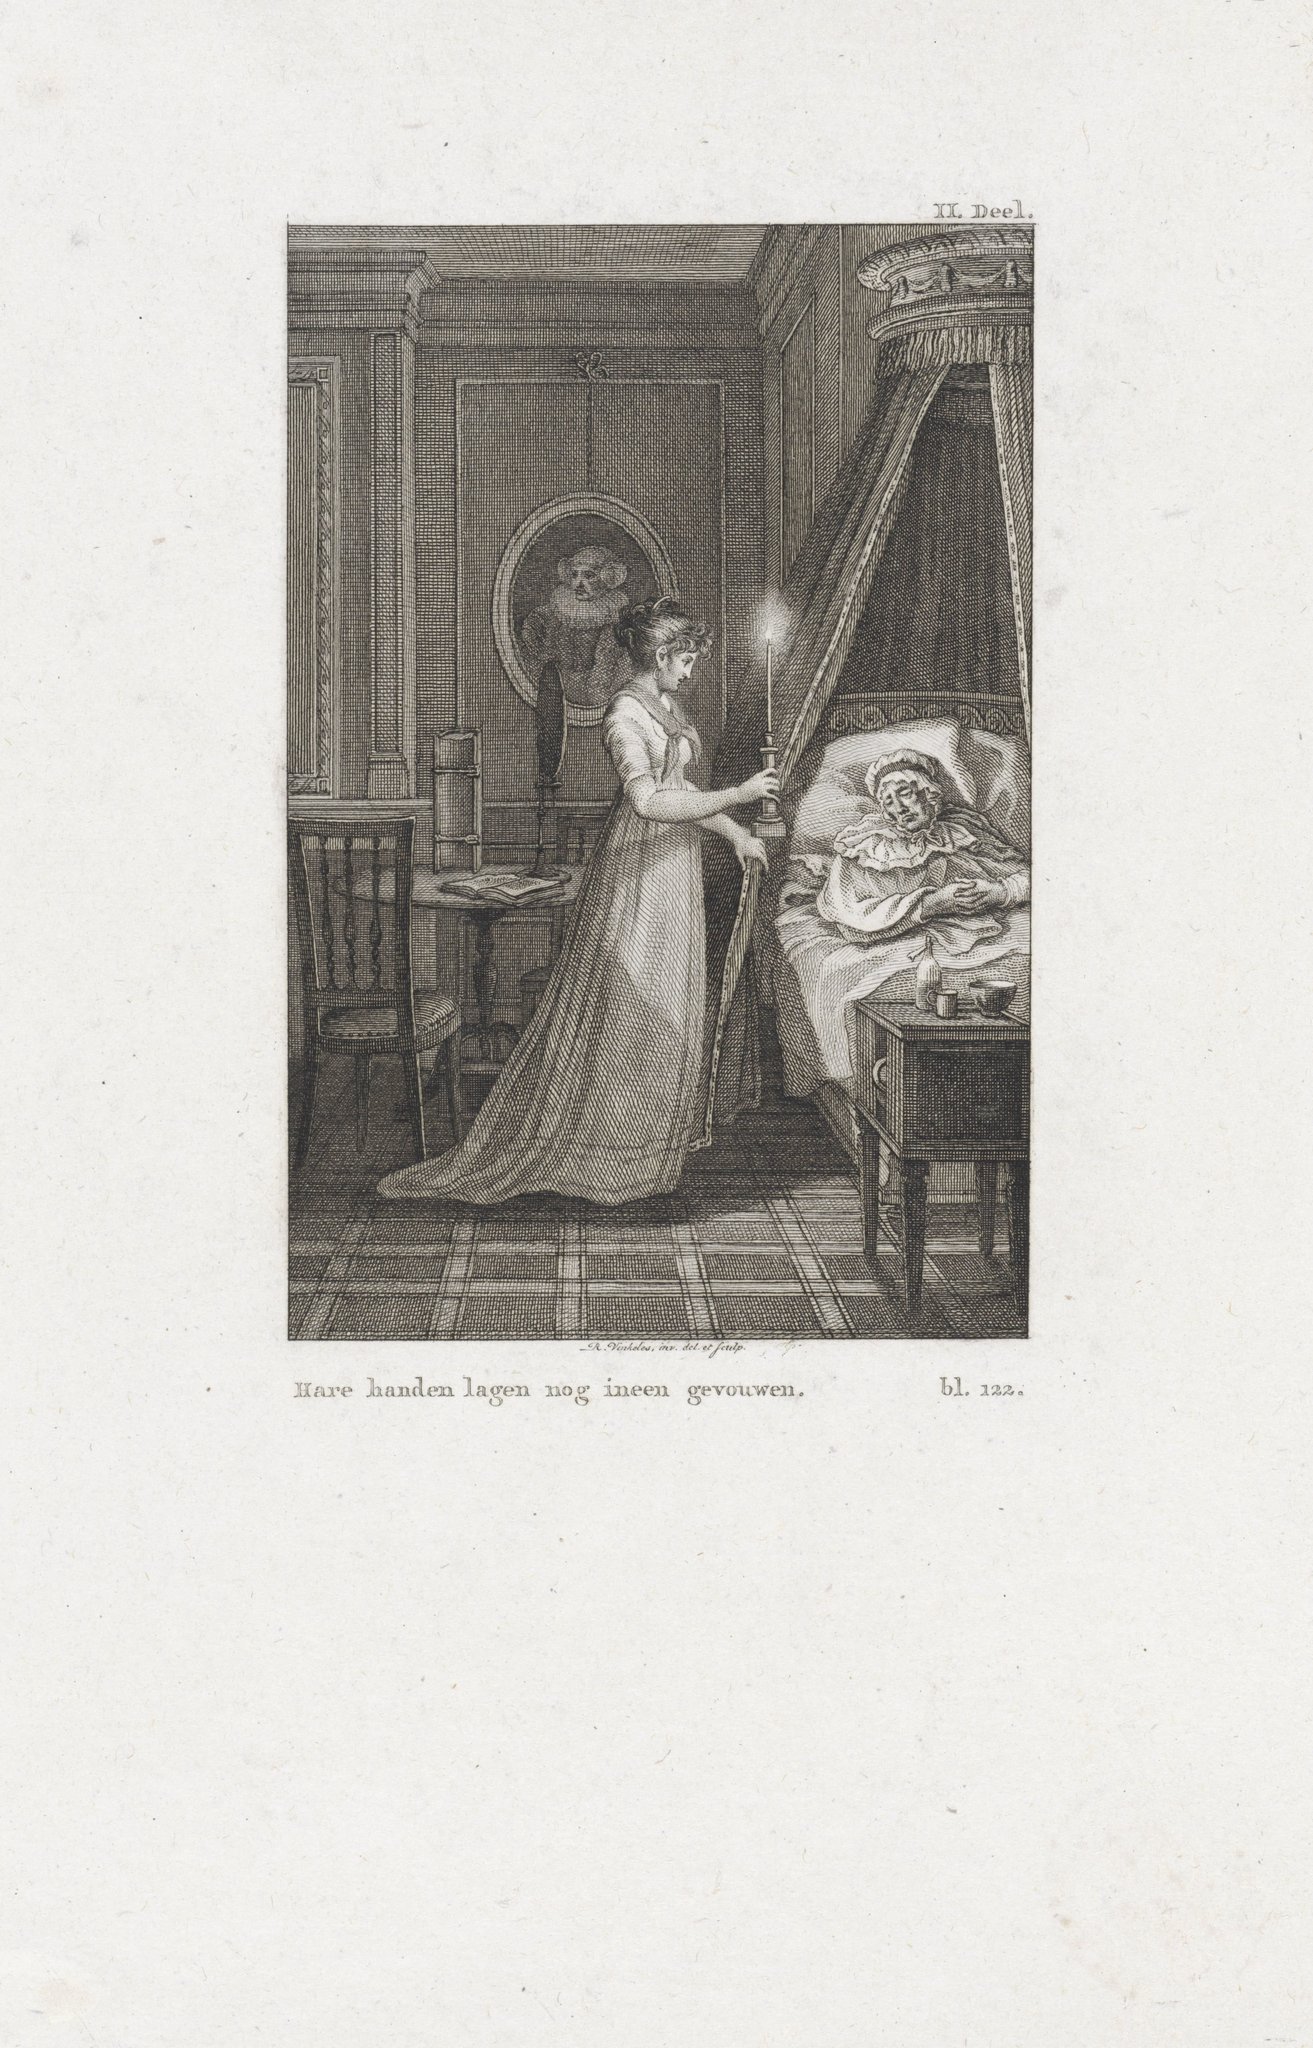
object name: print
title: Jonge vrouw bezoekt een oude slapende vrouw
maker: reinier vinkeles (i)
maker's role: draughtsman, print maker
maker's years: 1741-1816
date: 1806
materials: paper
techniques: engraving, etching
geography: amsterdam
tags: sleeping in bed, candle, picture, painting, bedroom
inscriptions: collector's mark: Lugt 240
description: Illustratie voor: Loosjes Pz., Adriaan. Historie van Mejuffrouw Susanna Bronkhorst. Haarlem: Adriaan Pz. Loosjes, 1806-1807.